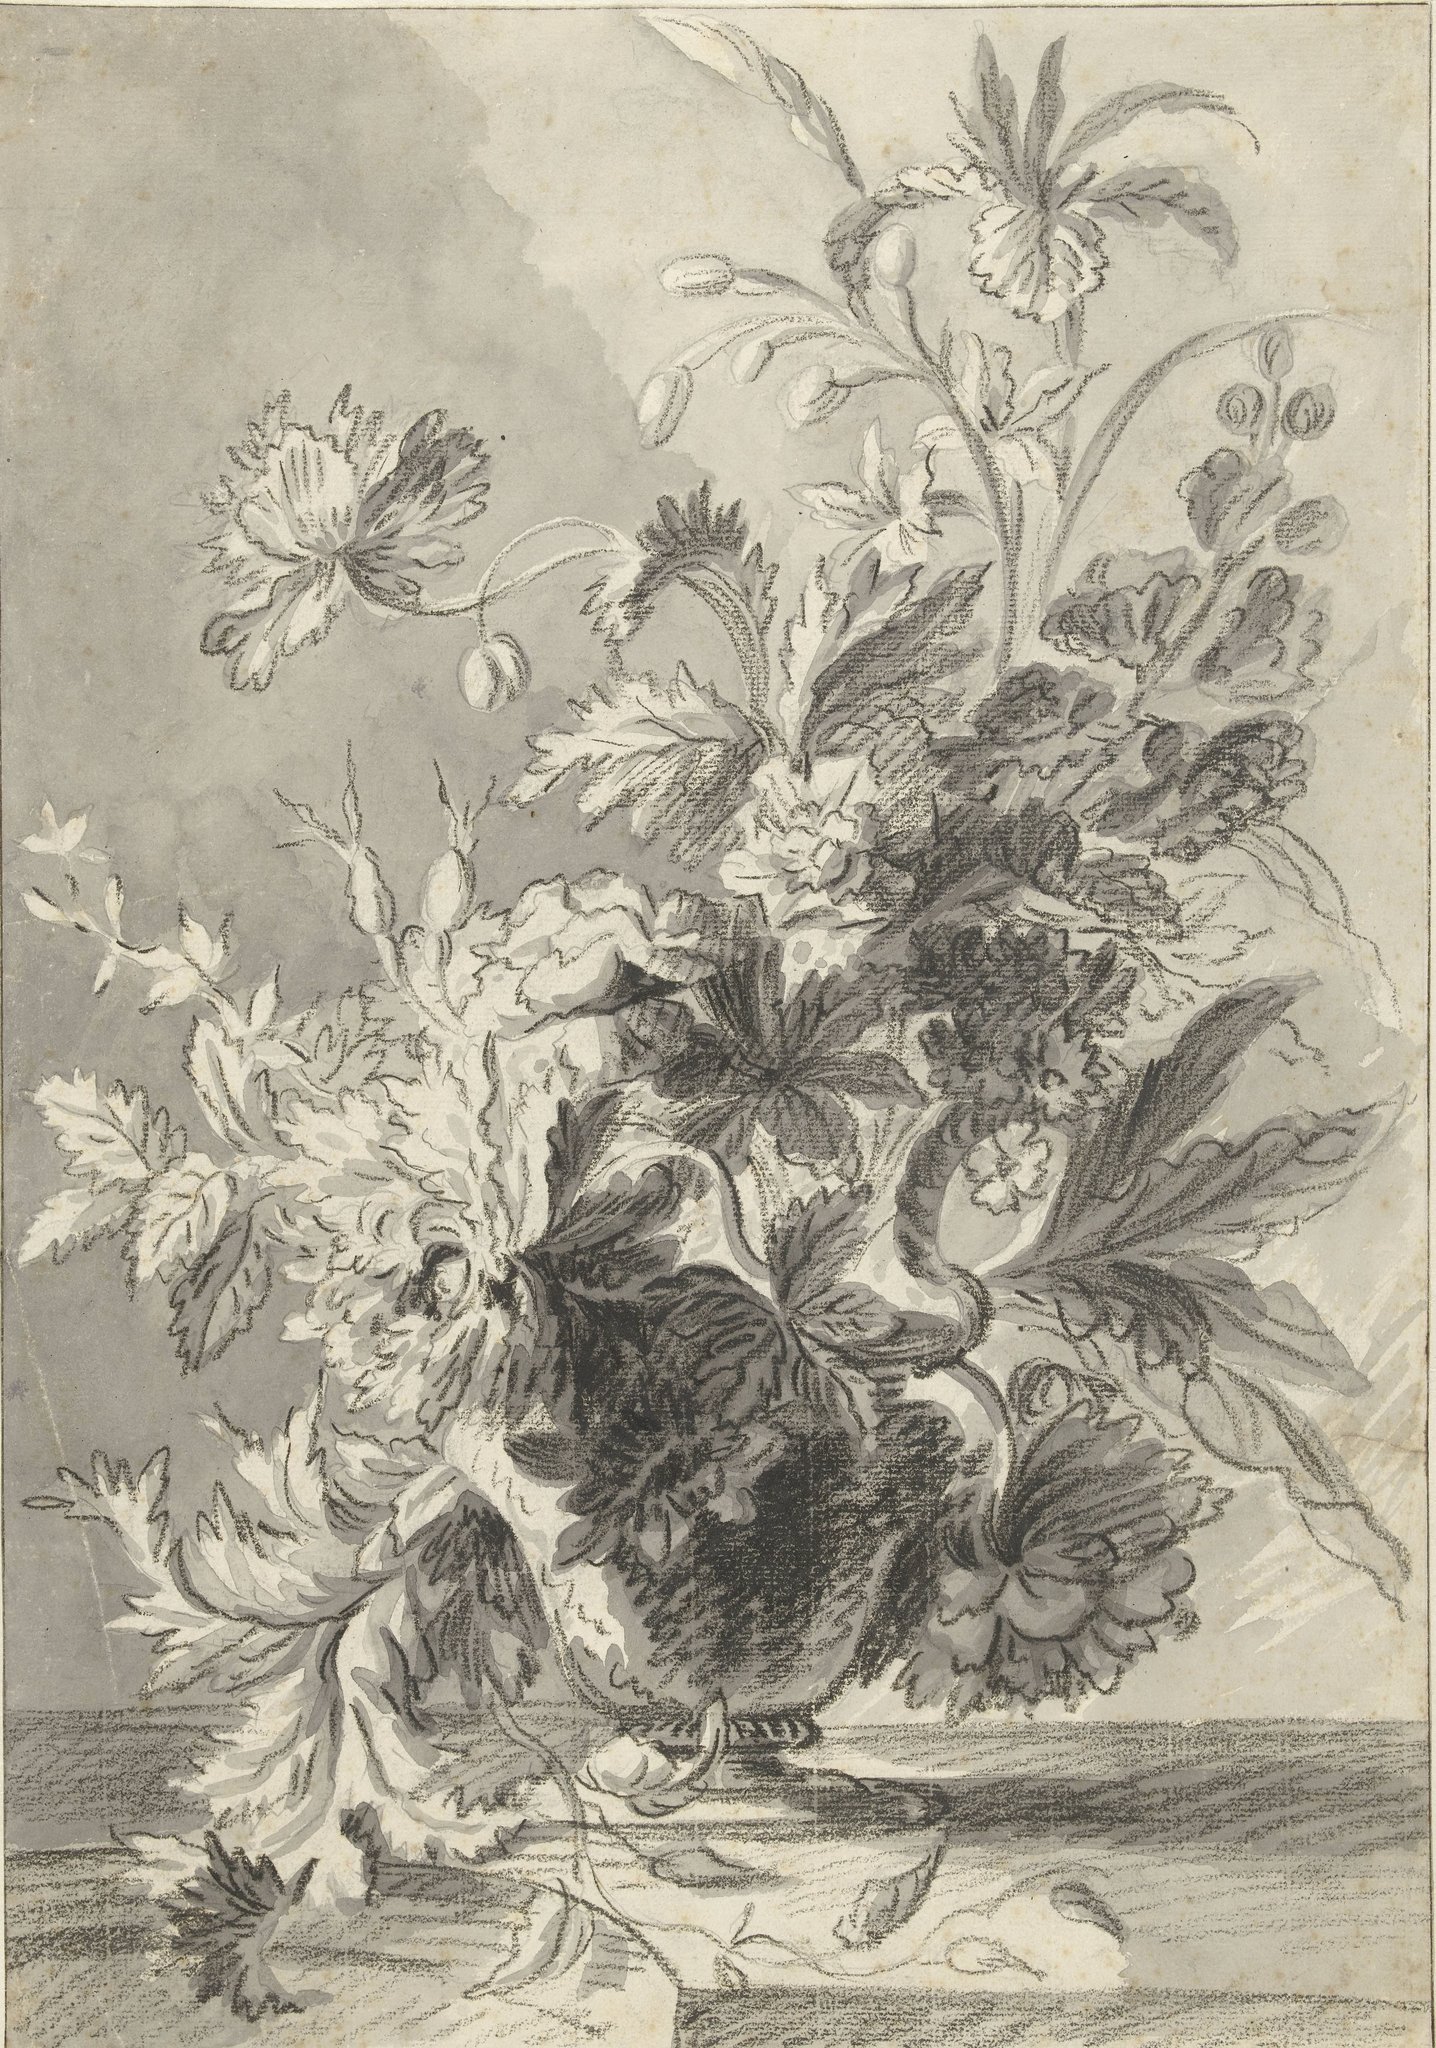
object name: drawing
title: Vaas met bloemen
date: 1692-1749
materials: ink, paper, pencil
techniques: brush, pen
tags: flowers in a vase